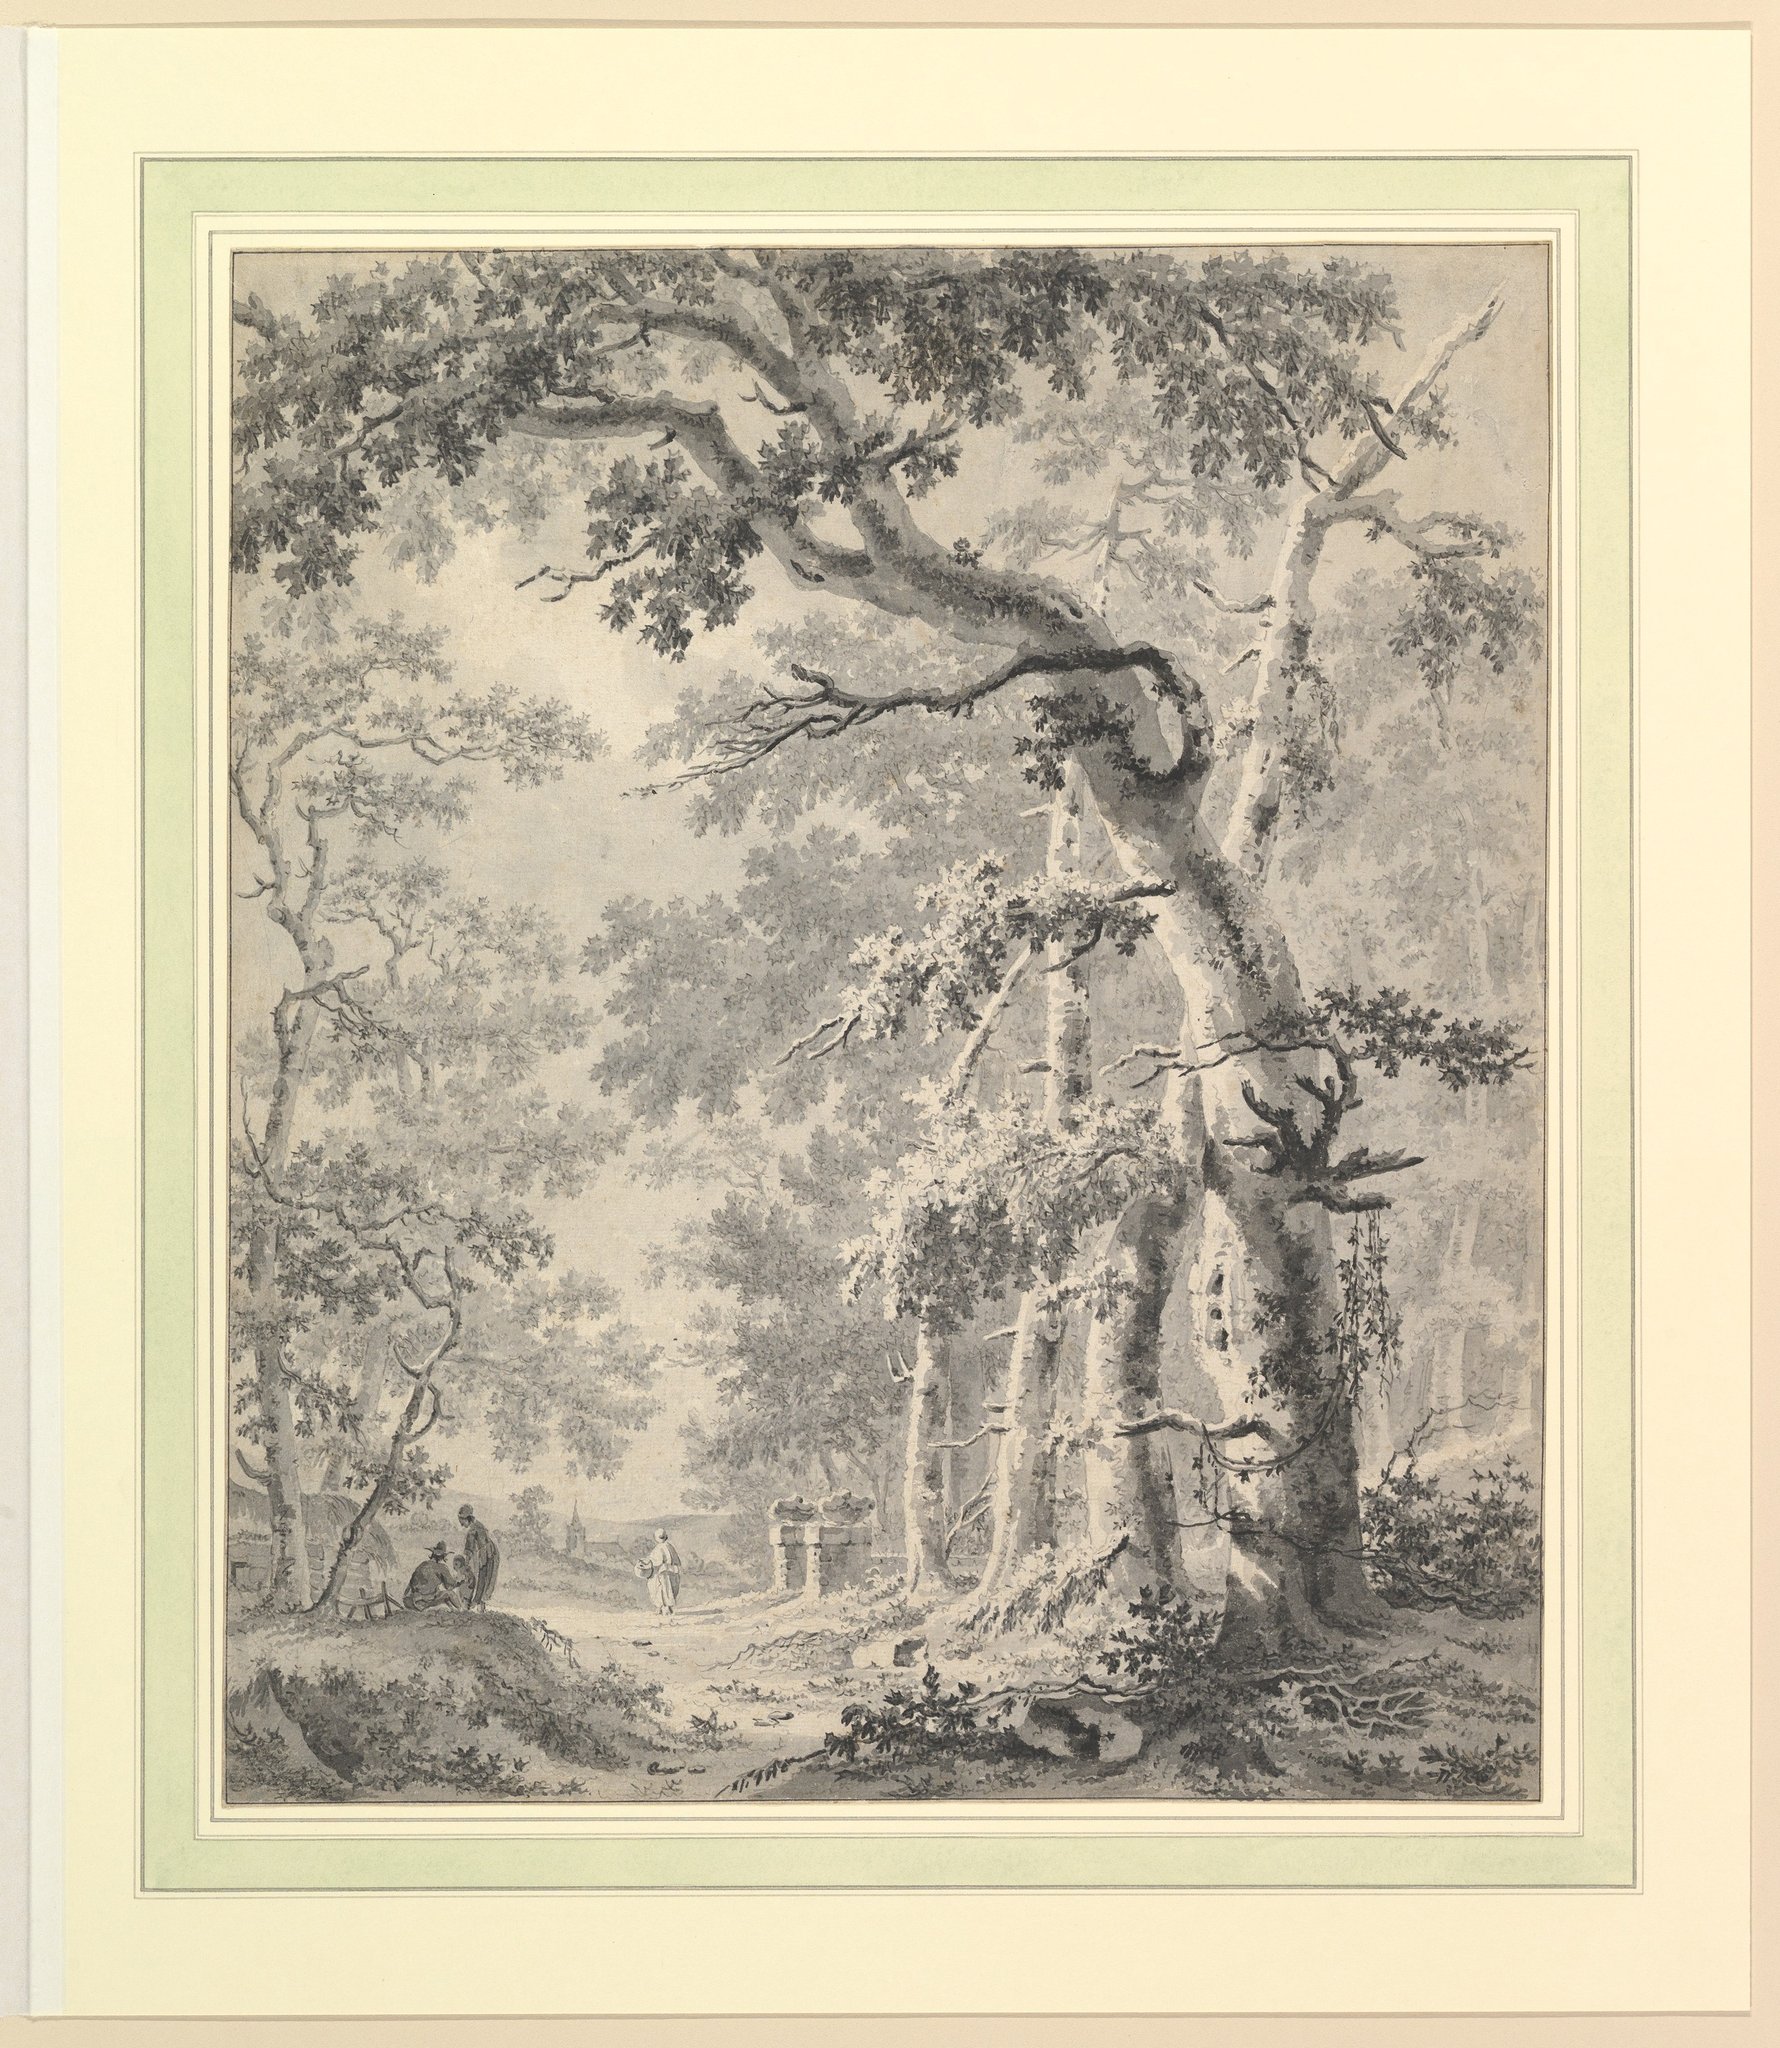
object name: drawing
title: Wooded Landscape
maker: paulus van liender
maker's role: draughtsman, print maker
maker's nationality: dutch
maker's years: 1731-1797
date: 1701-1800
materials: graphite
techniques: wash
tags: landscapes,trees